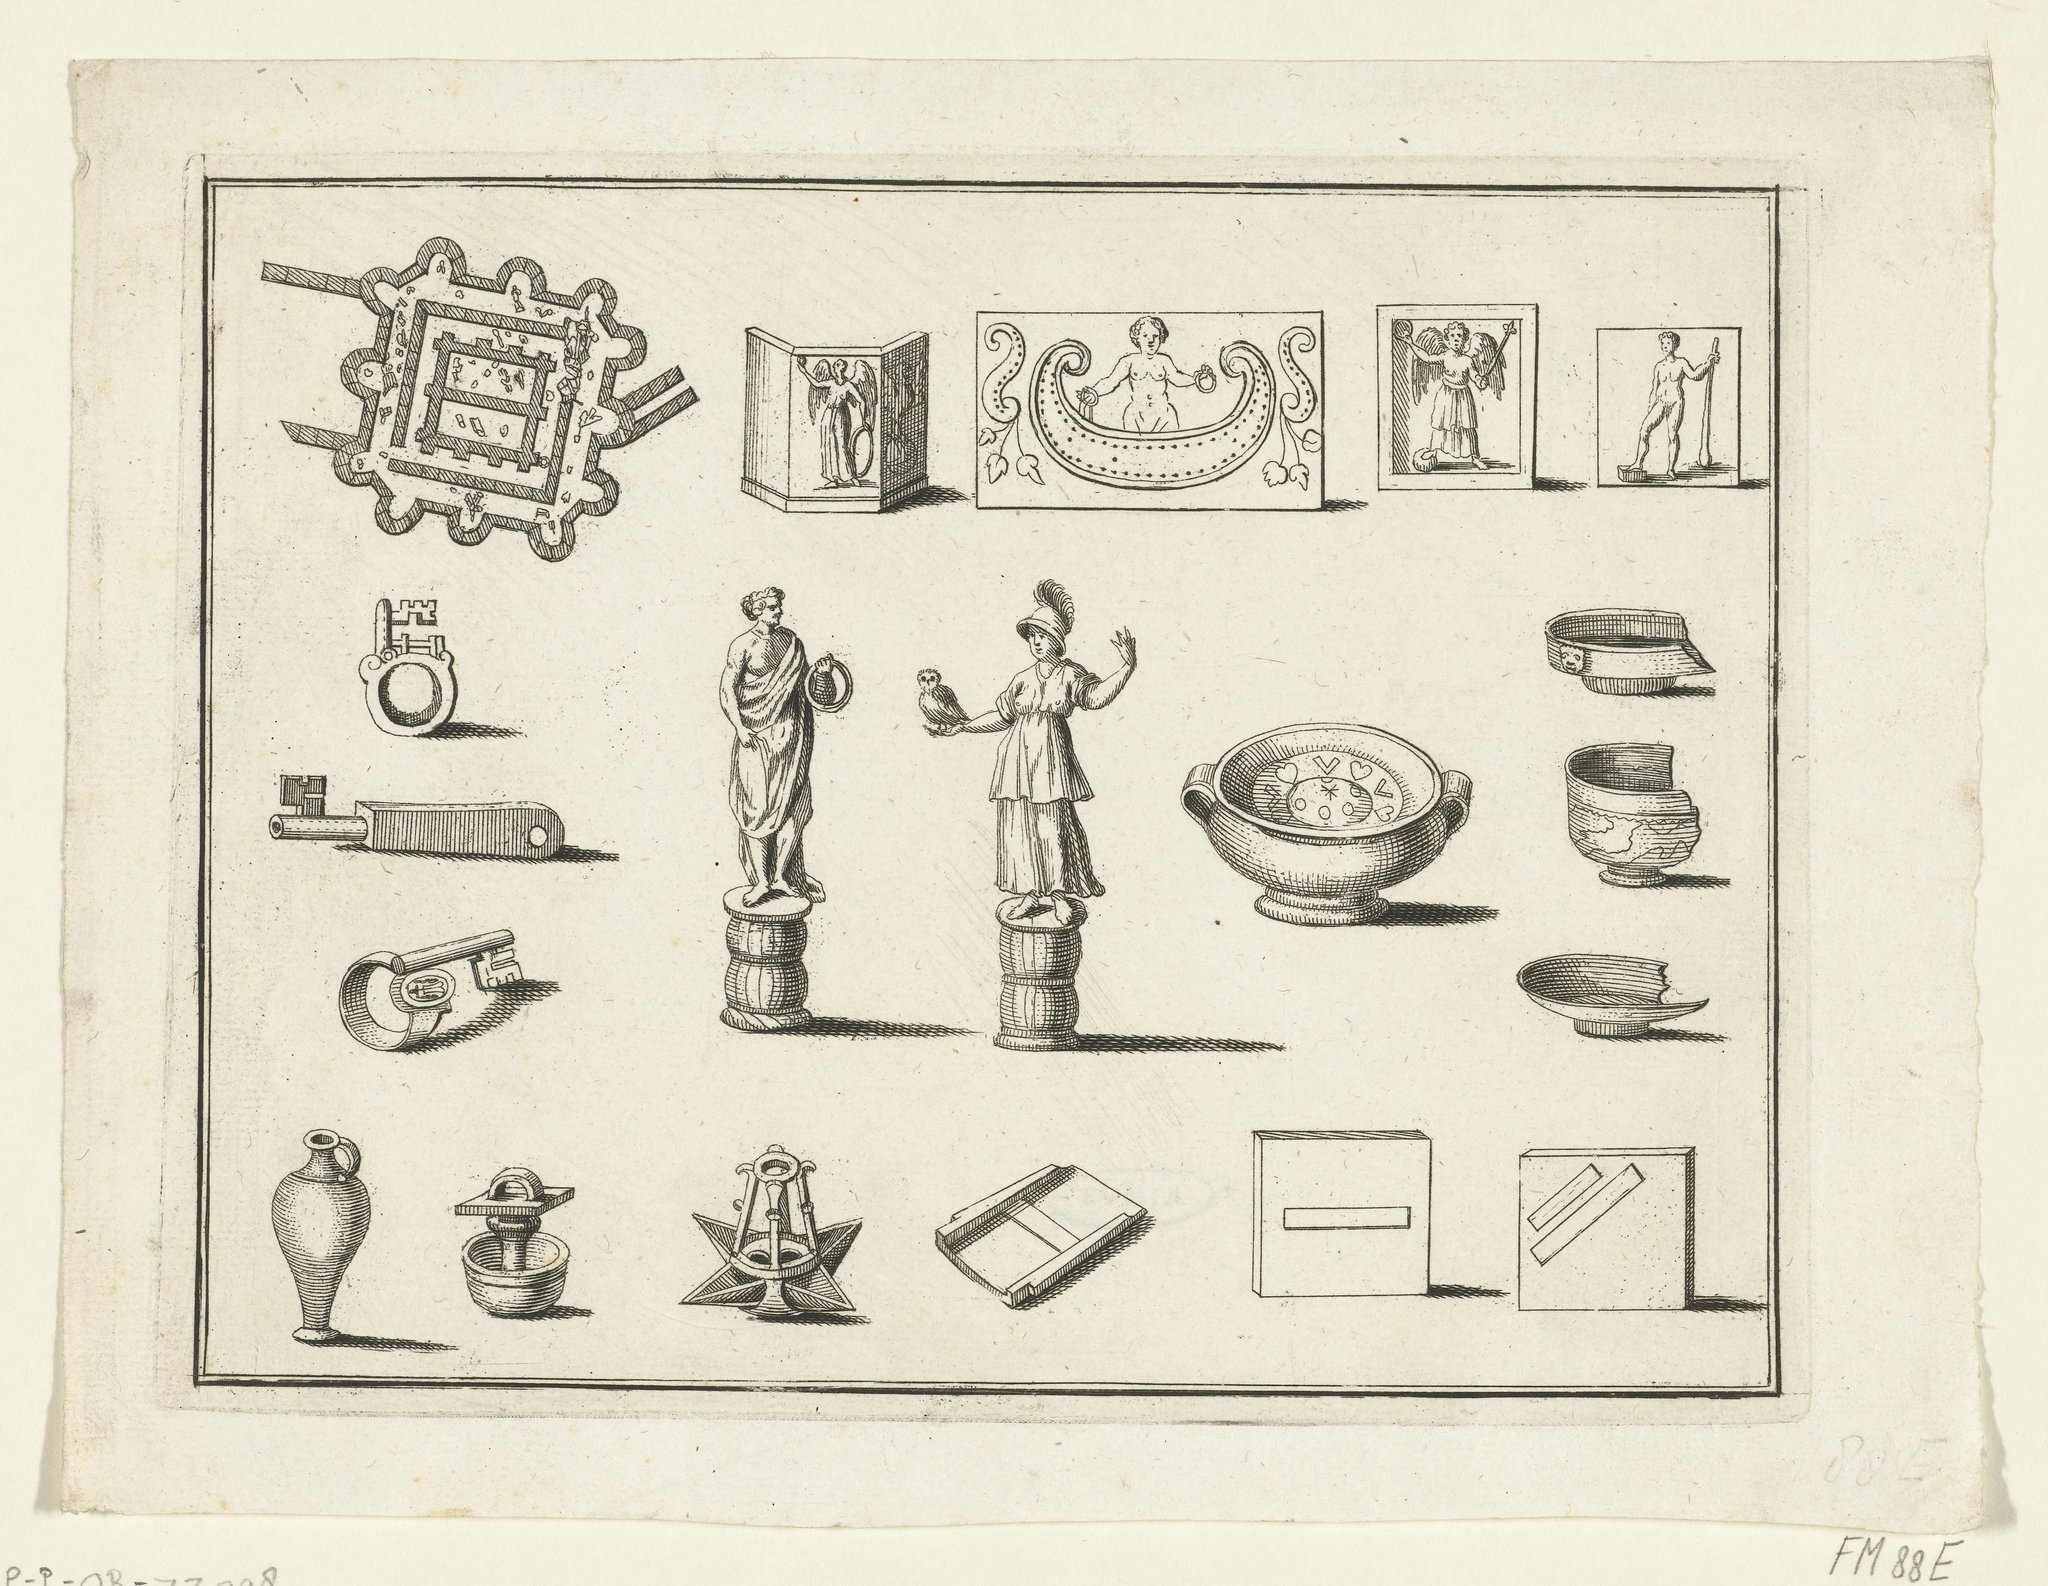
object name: historical object representation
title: De Brittenburg bij Katwijk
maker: Anonymous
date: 1650-1750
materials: paper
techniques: etching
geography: northern netherlands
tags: huis te britten, romeinse periode in nederland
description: Illustratie voor een onbekend werk. Staat vóór de letter van de tweede prent beschreven onder nummer FMH 88C. Niet in Frederik Muller; door het RPK toegevoegd nummer.